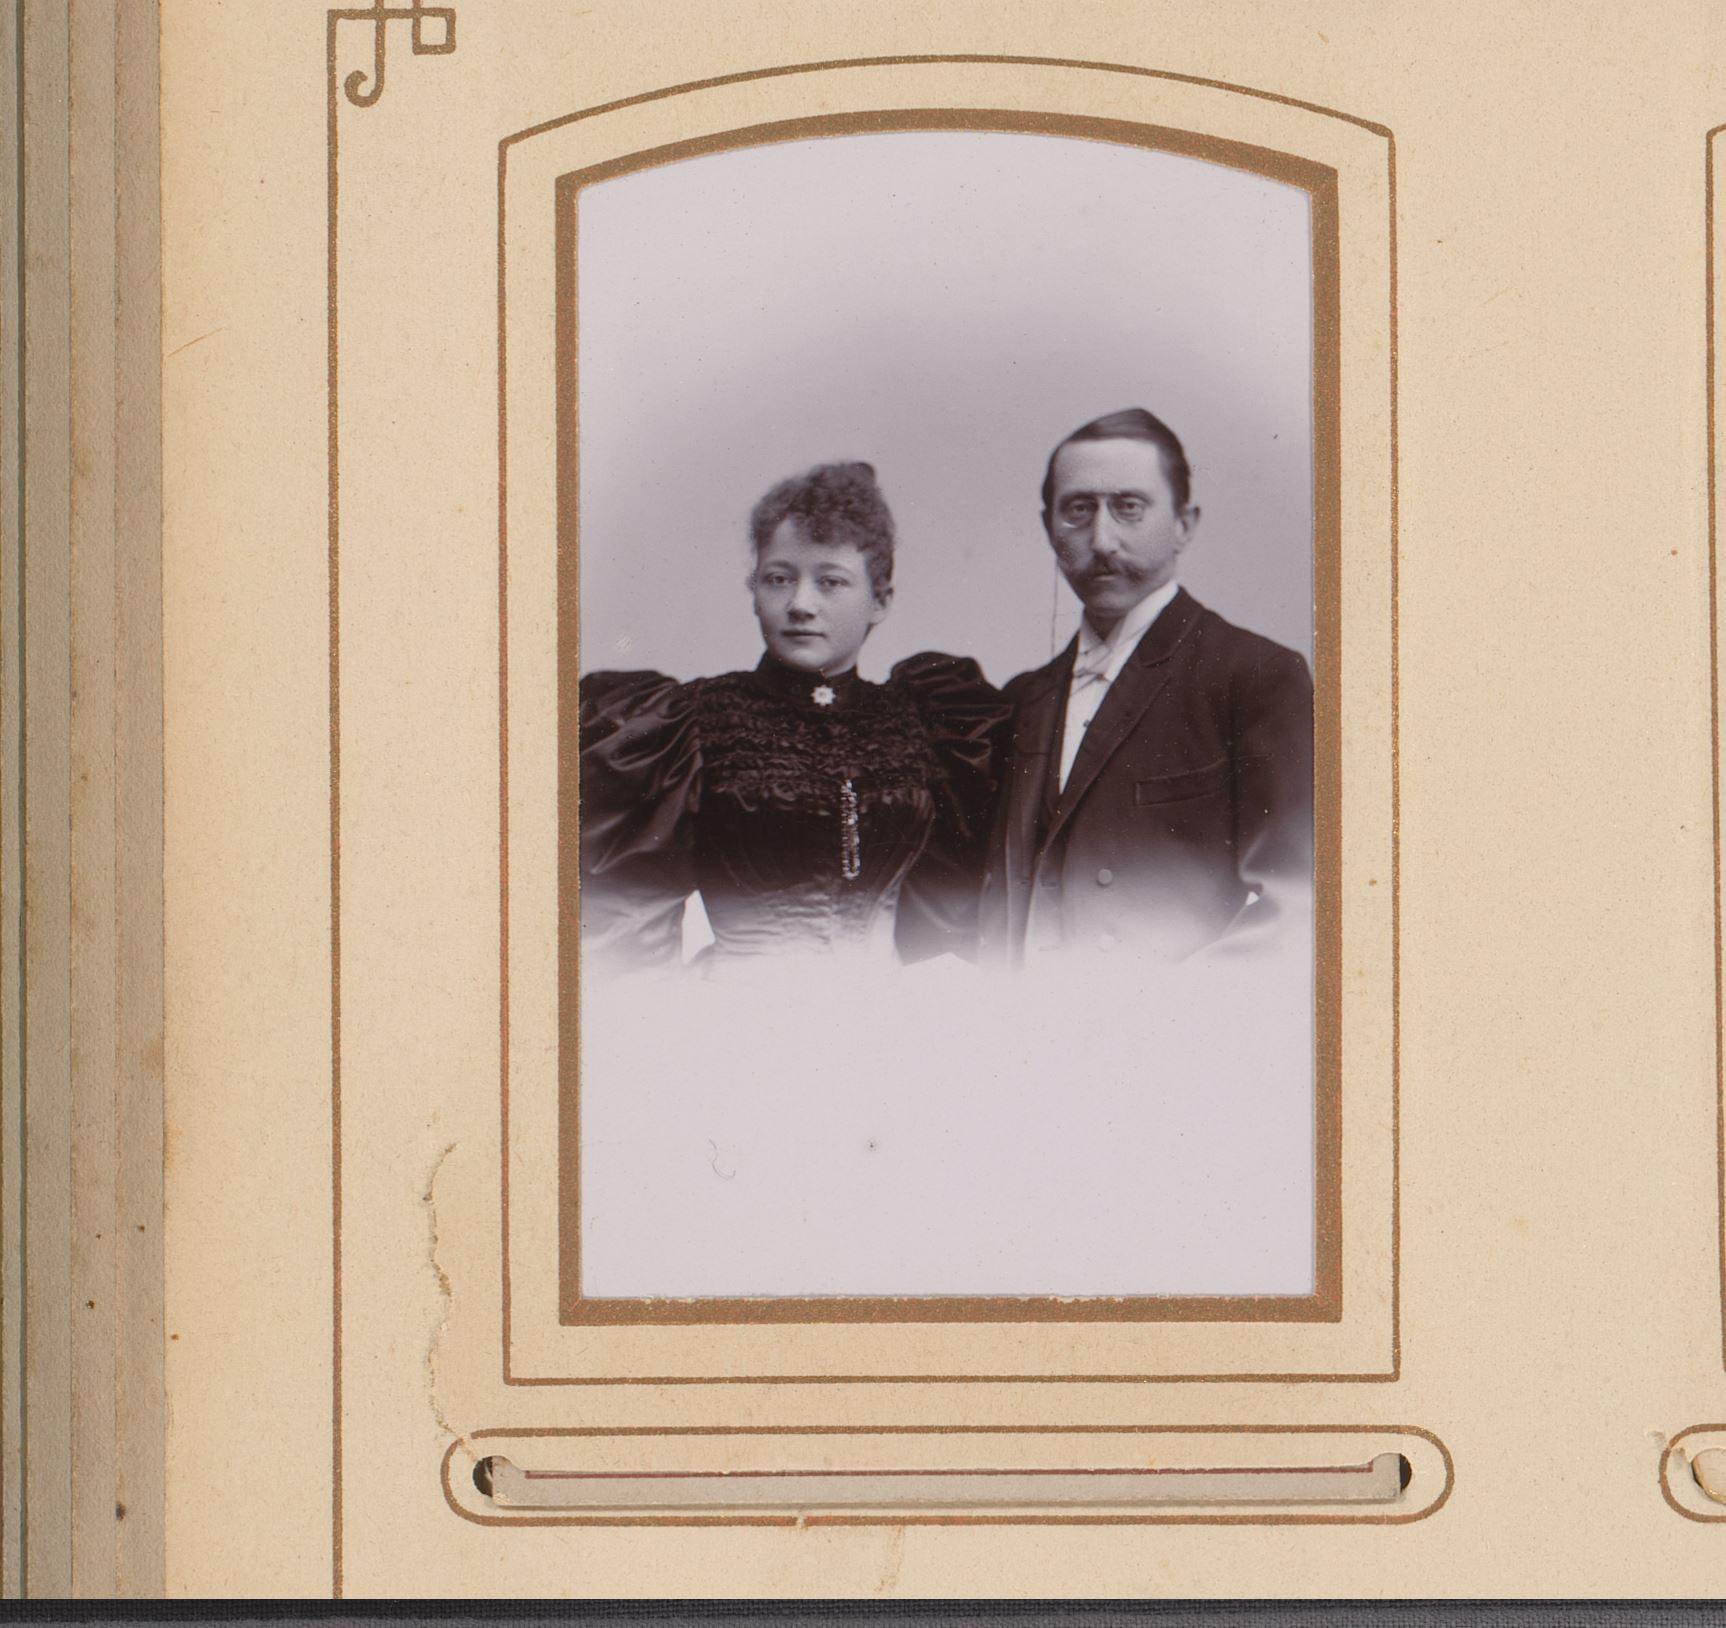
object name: album leaf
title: Portret van een echtpaar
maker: Anonymous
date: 1890-1910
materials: cardboard, photographic support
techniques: collodion silver print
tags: couple of lovers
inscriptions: annotation: ‘[...]’